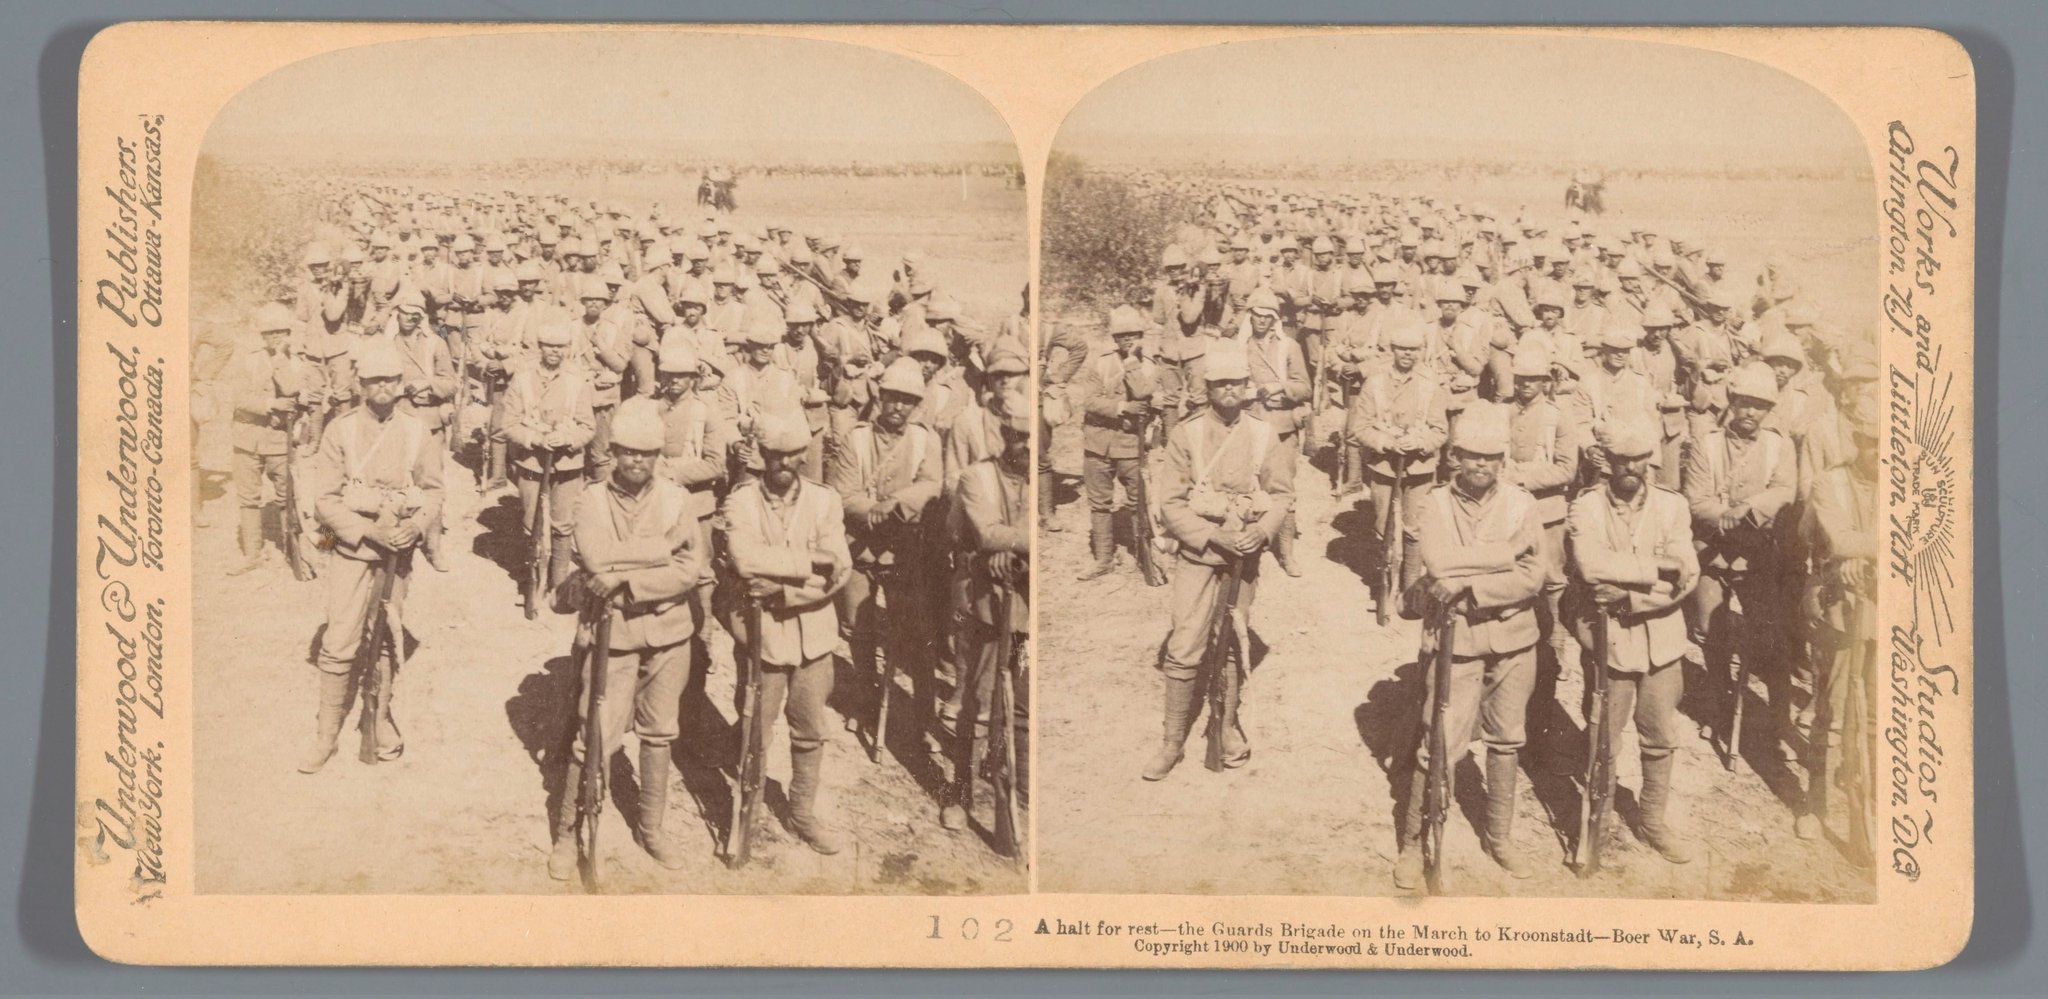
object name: stereograph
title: Britse soldaten marcheren naar Kroonstad, Zuid-Afrika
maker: Anonymous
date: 1900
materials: cardboard, paper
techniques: albumen print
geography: kroonstad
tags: marching away (troops)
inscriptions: inscription, copyright notice: ‘Copyright 1900 by Underwood & Underwood.’, inscription: ‘Works and Studios ~/ Arlington, N.J. Littleton, N.H. Washington, D.C.’, number: ‘102’